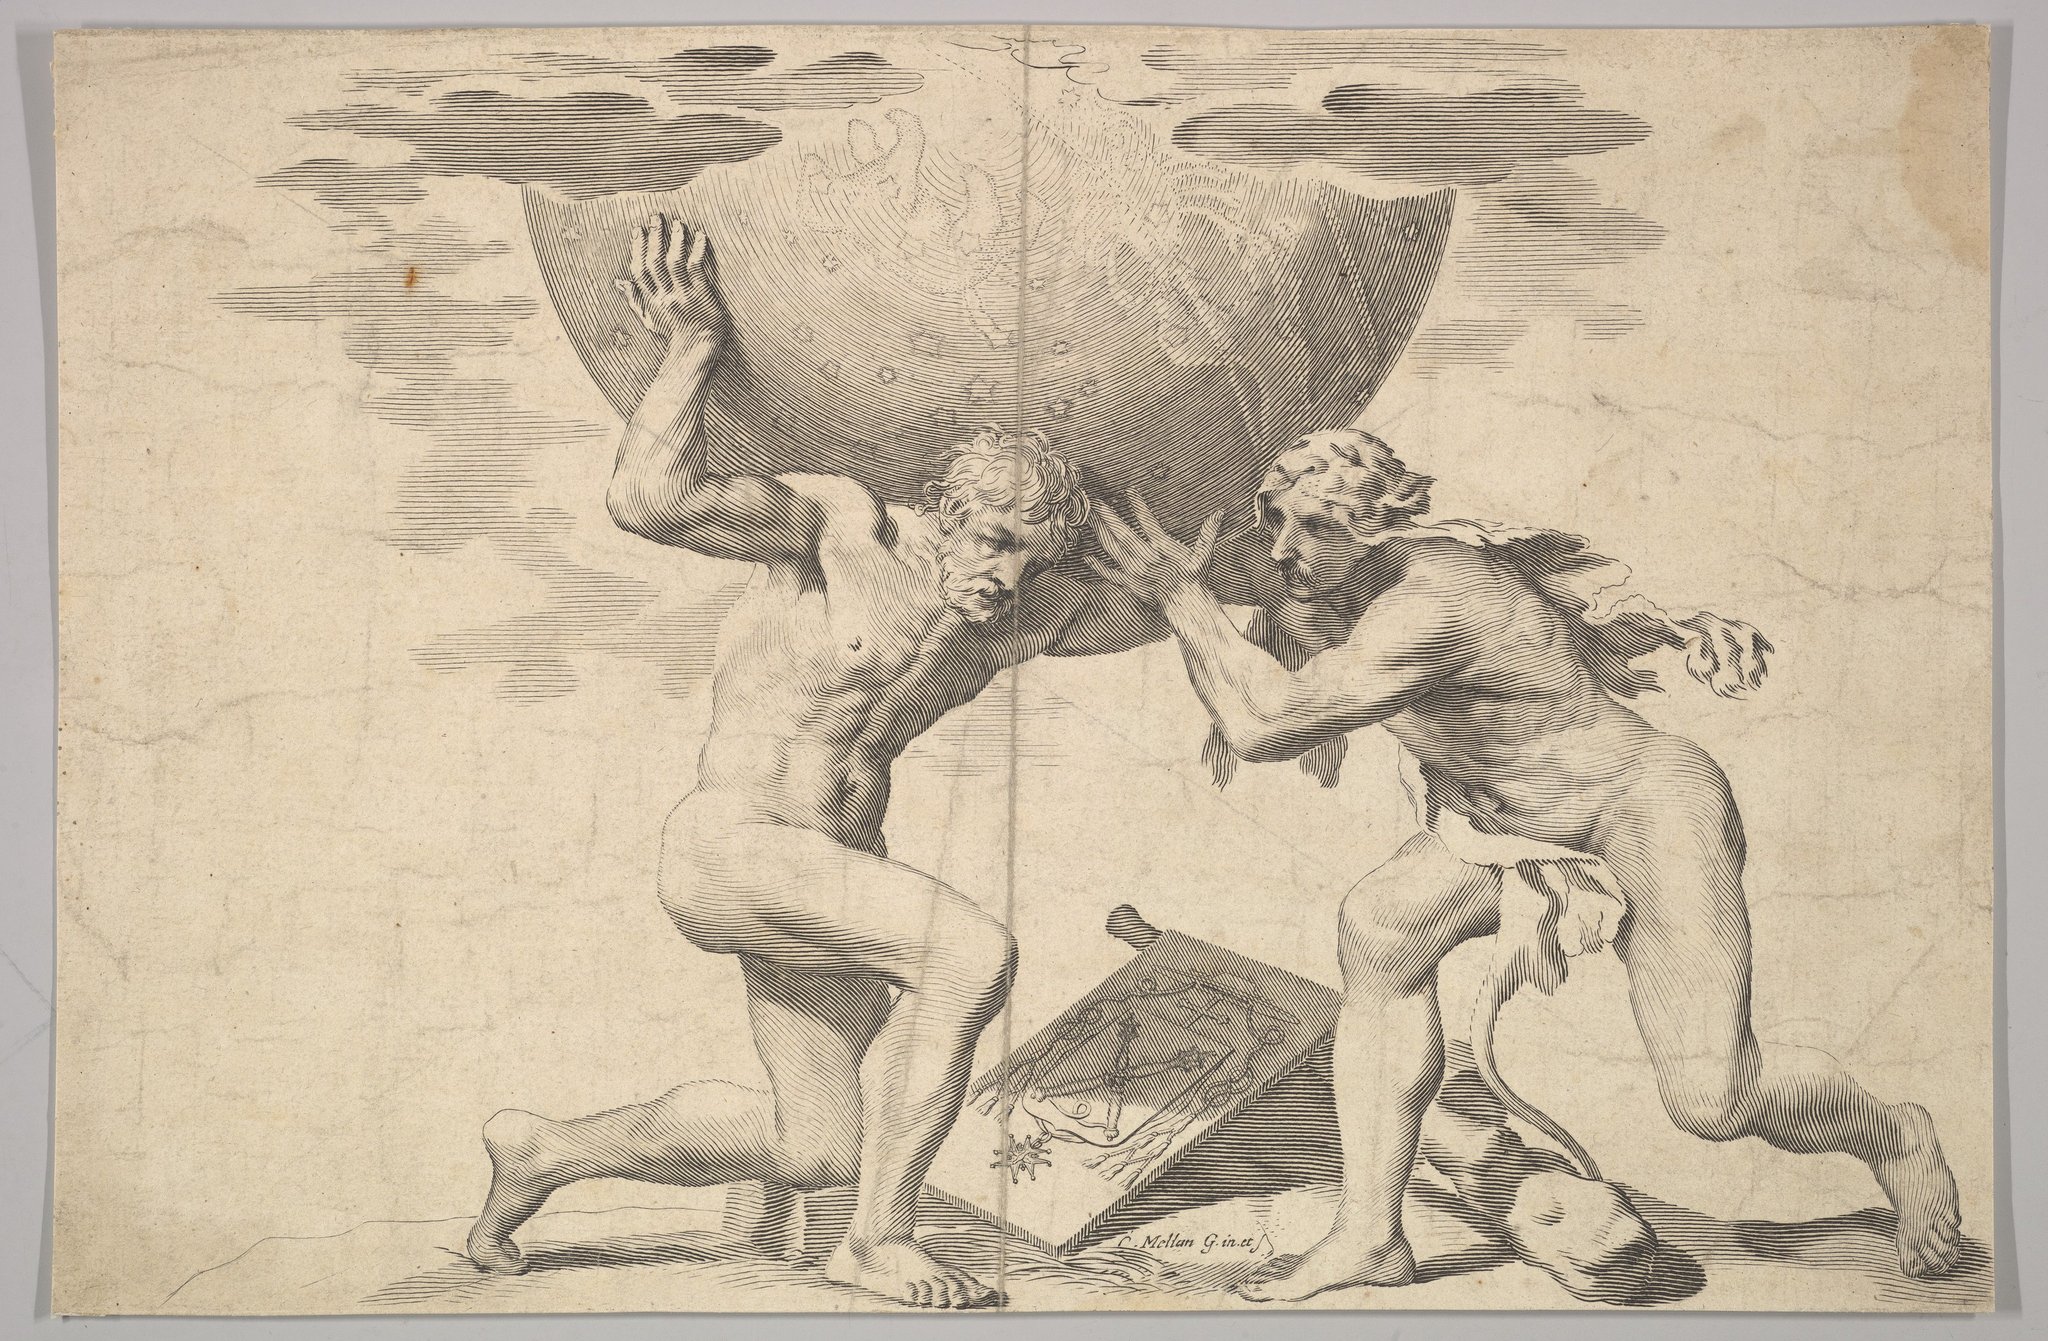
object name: print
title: Hercules Assisting Atlas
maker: claude mellan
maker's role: artist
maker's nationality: french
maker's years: 1598-1688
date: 1620-1680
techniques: engraving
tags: male nudes,hercules,globes